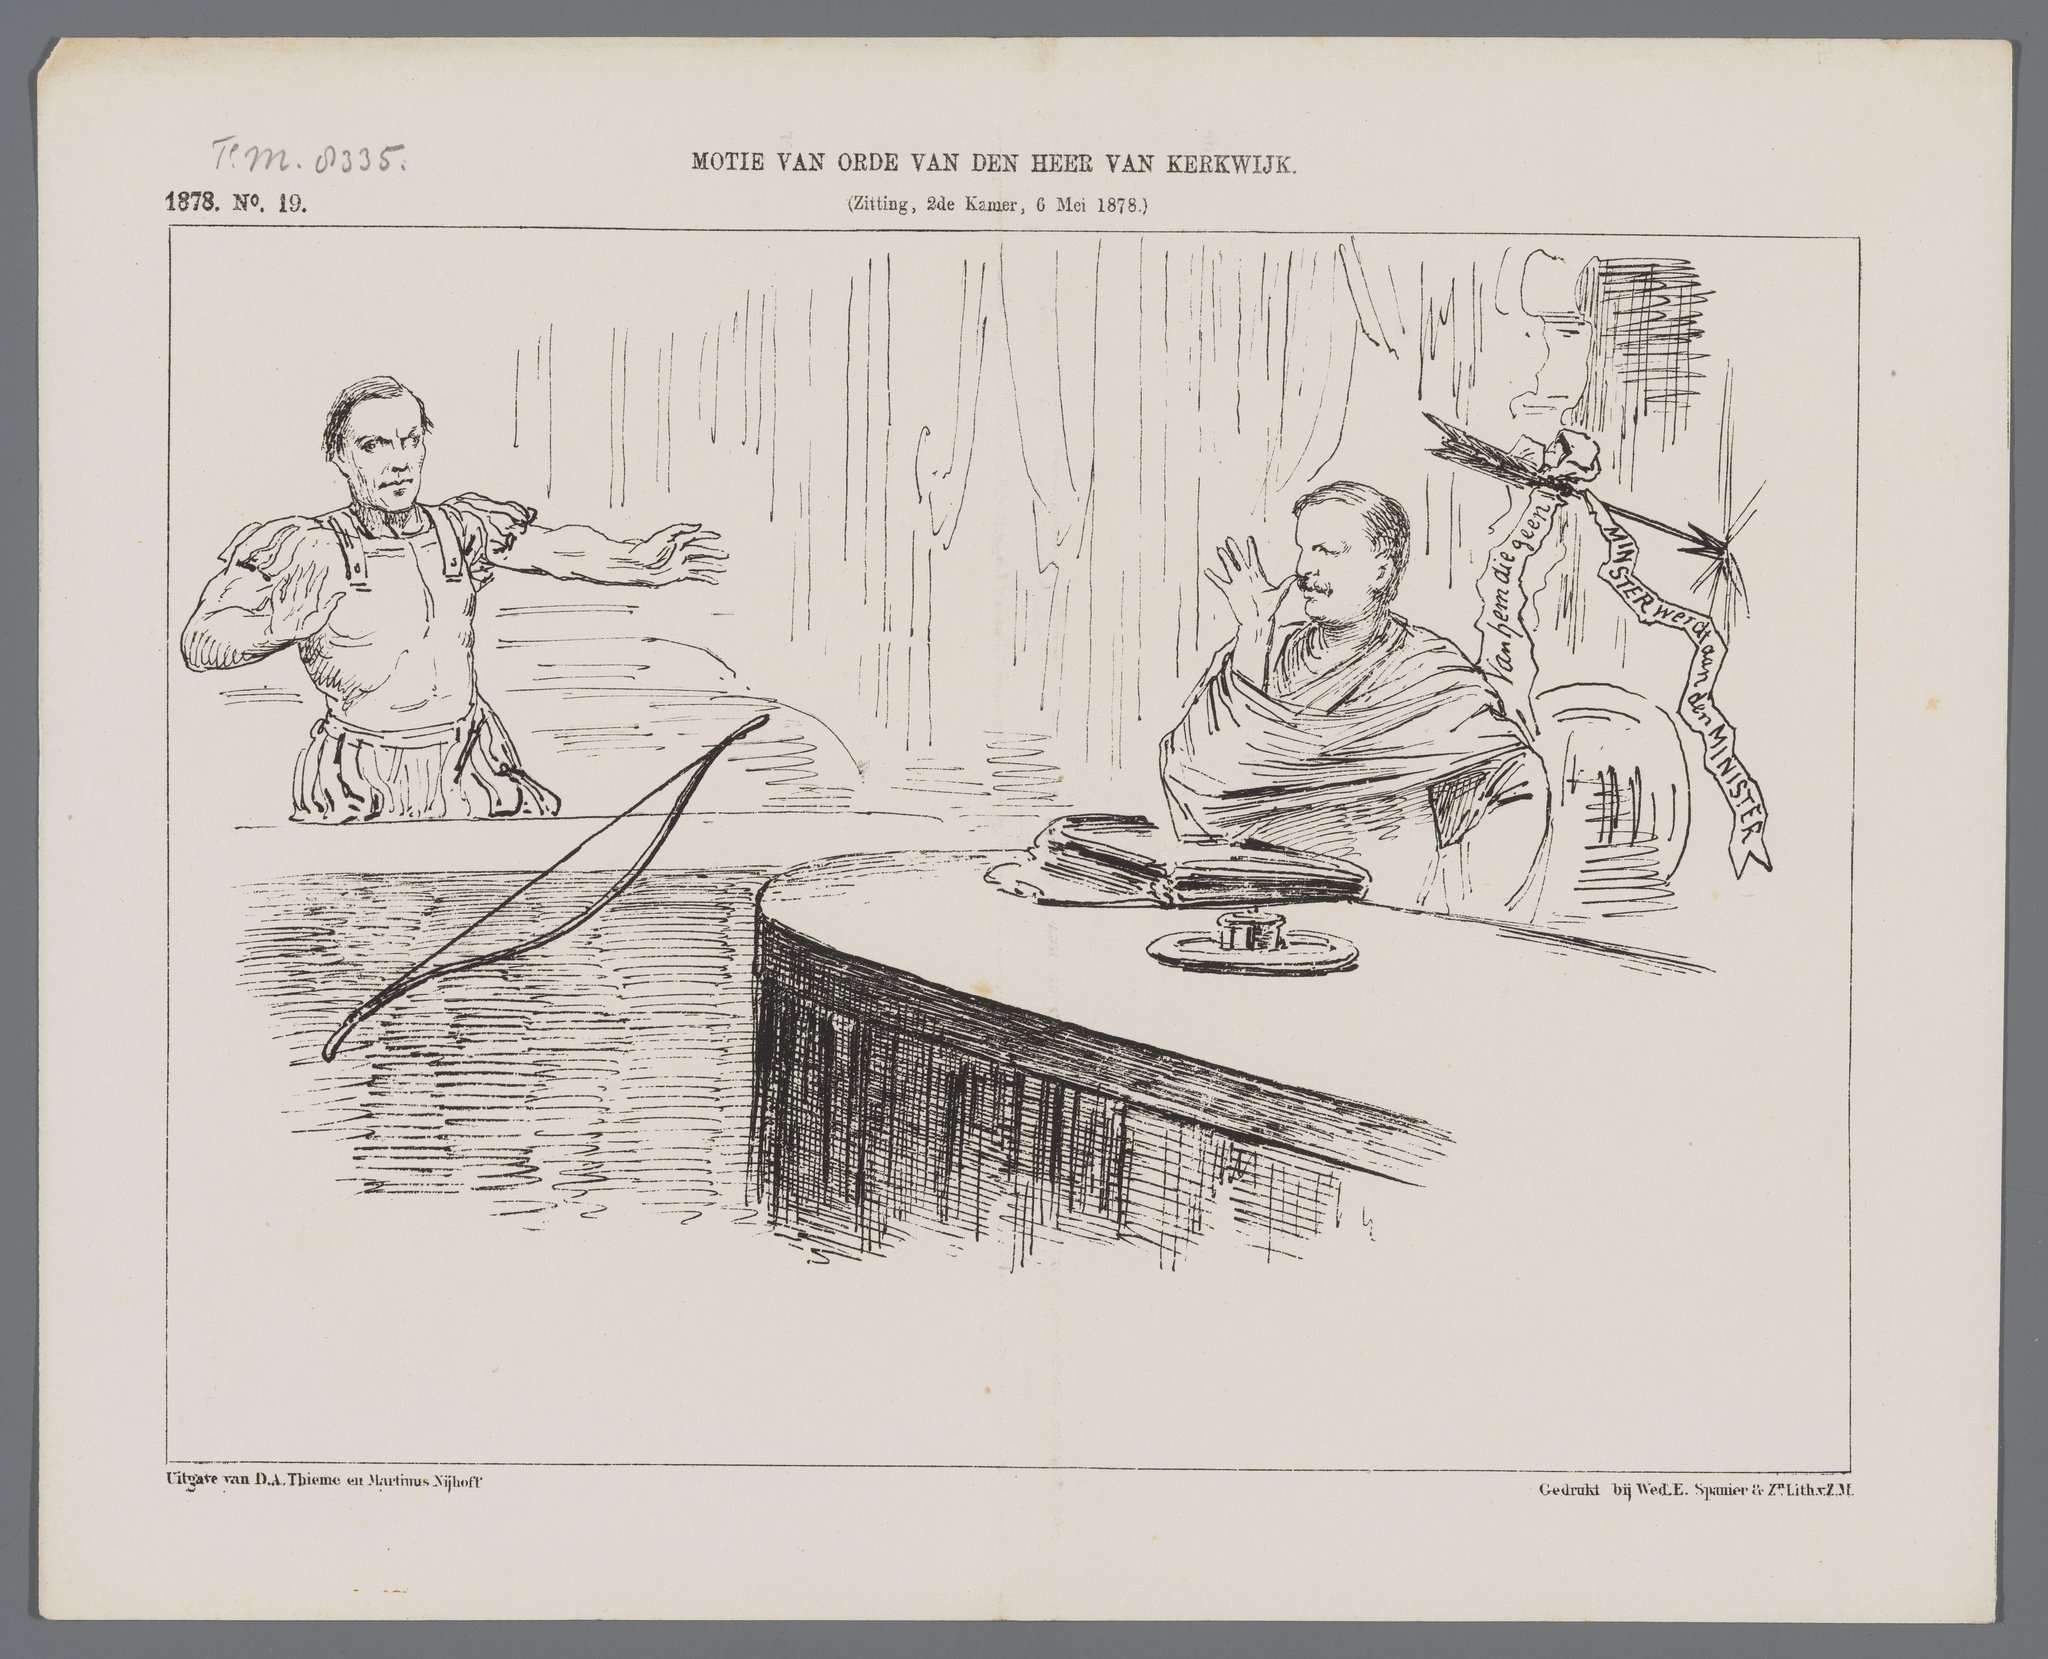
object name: cartoon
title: Motie van orde van den heer Van Kerkwijk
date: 1878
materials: paper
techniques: lithograph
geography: netherlands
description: Spotprent. Plaat verschenen bij het weekblad De Nederlandsche Spectator, nr. 19, 1878.